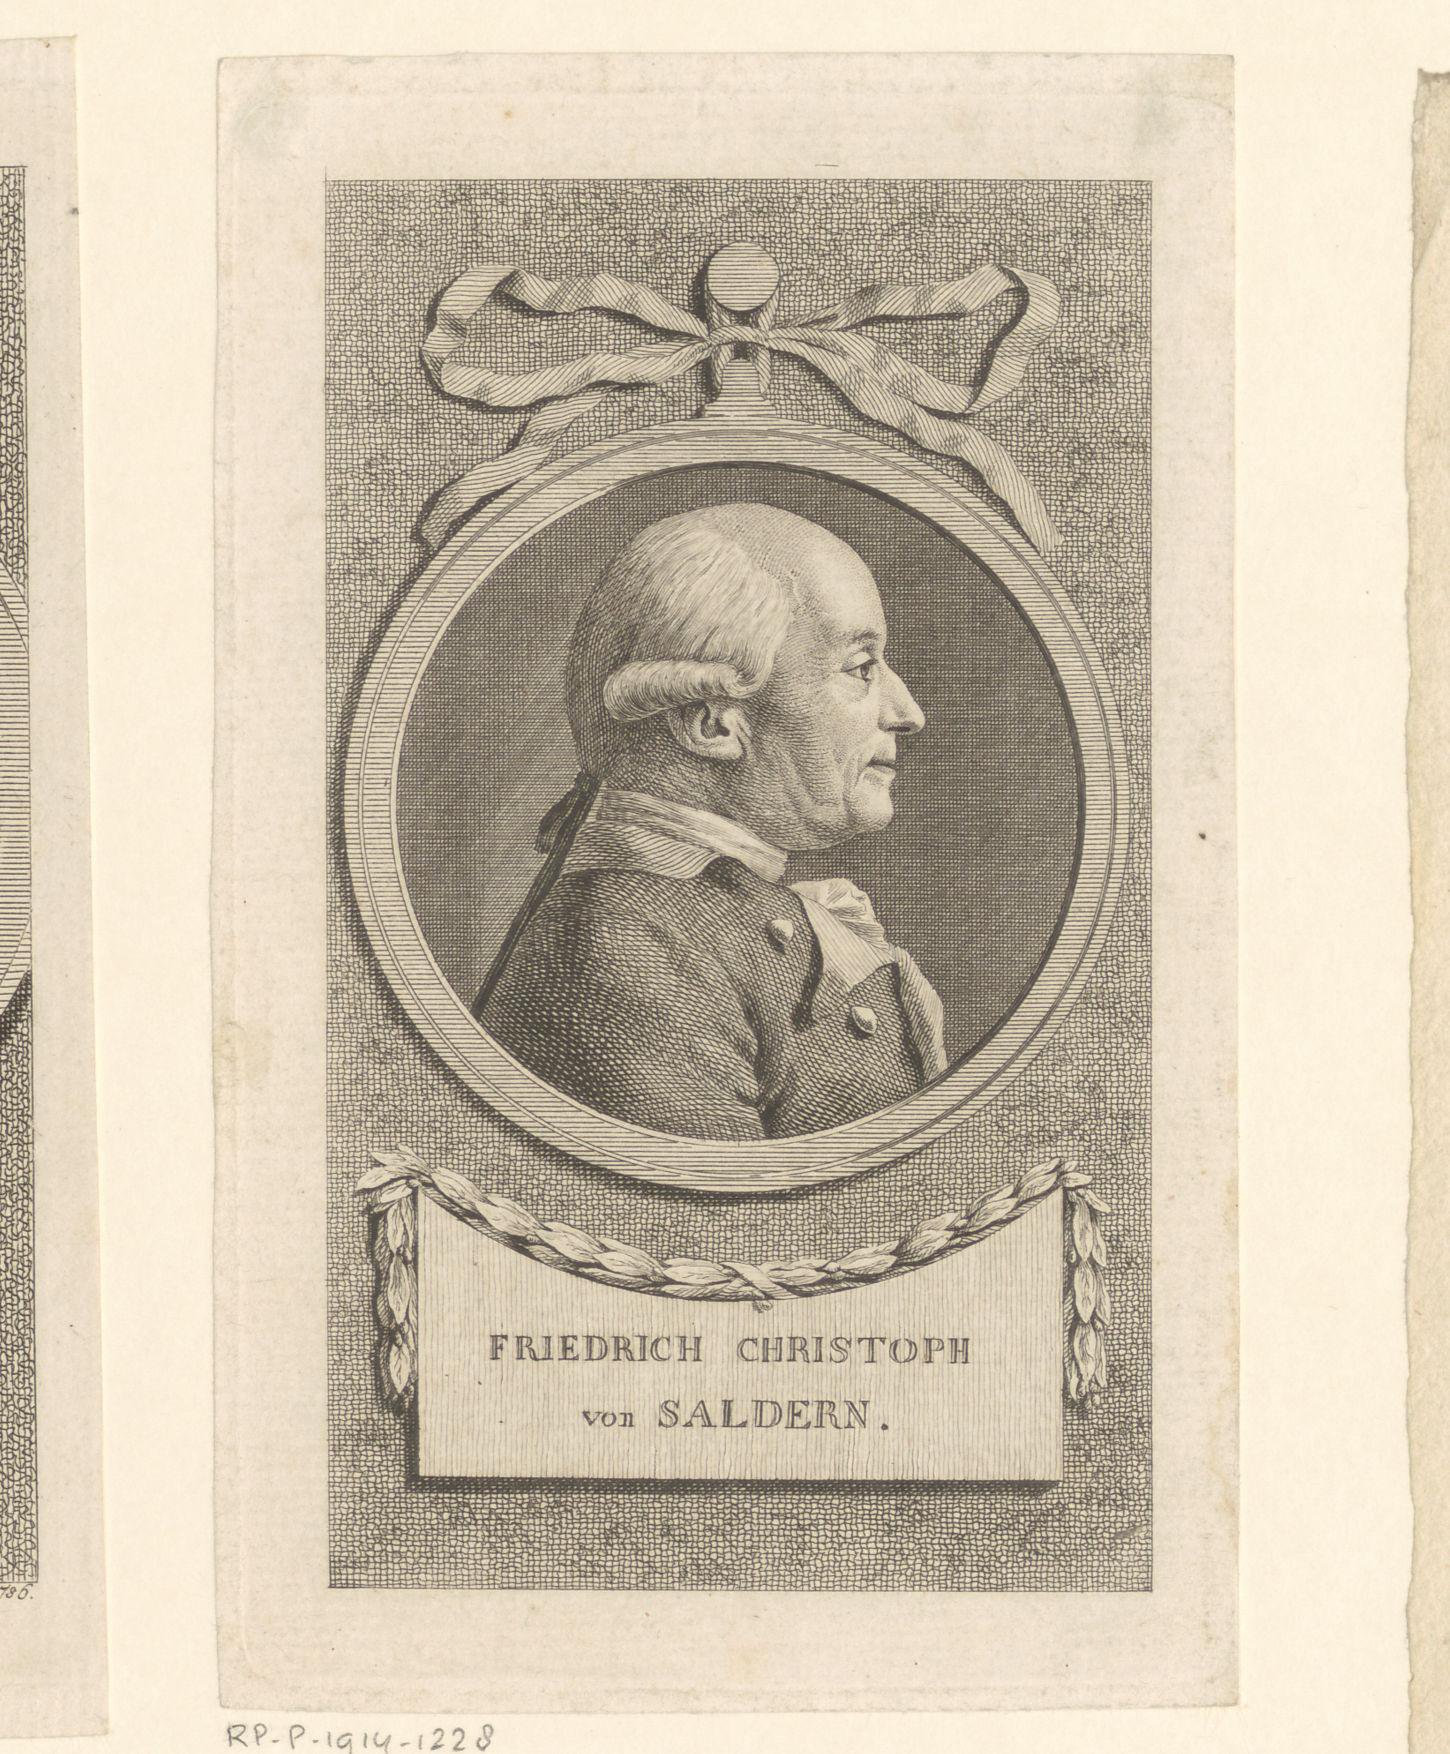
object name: print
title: Portret van Friedrich Christoph von Saldern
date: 1750-1800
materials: paper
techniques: engraving, etching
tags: historical persons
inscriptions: collector's mark: Lugt 2228